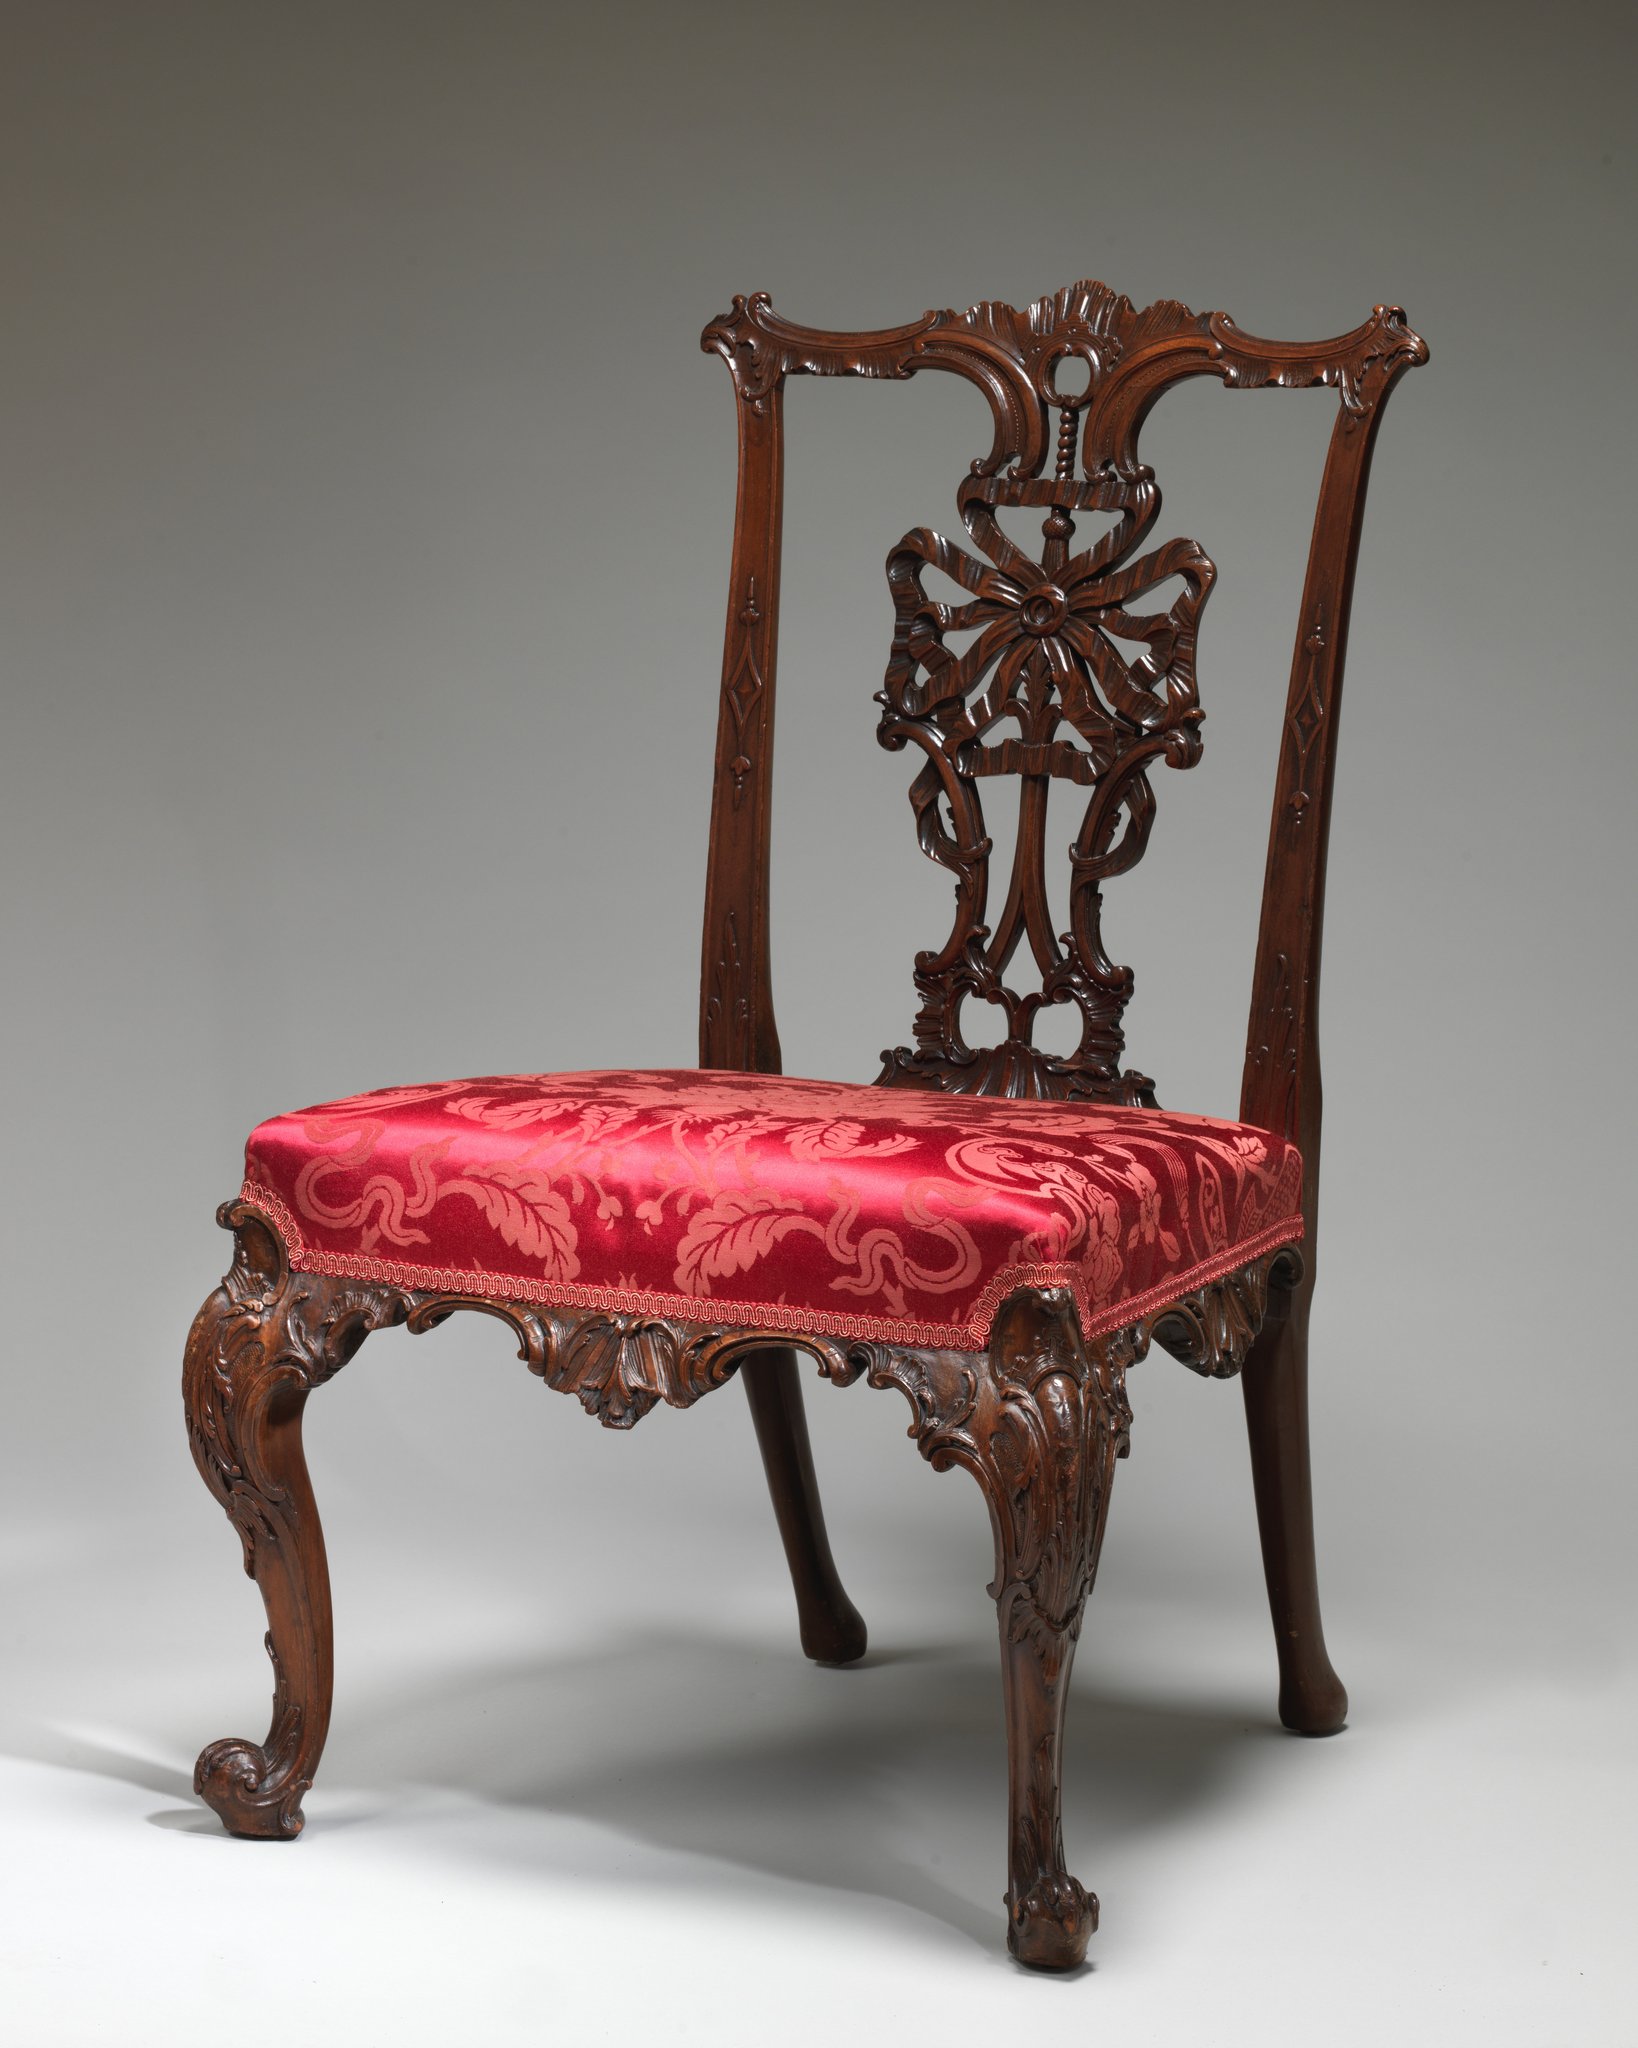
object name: side chair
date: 1734-1766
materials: wood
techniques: damask